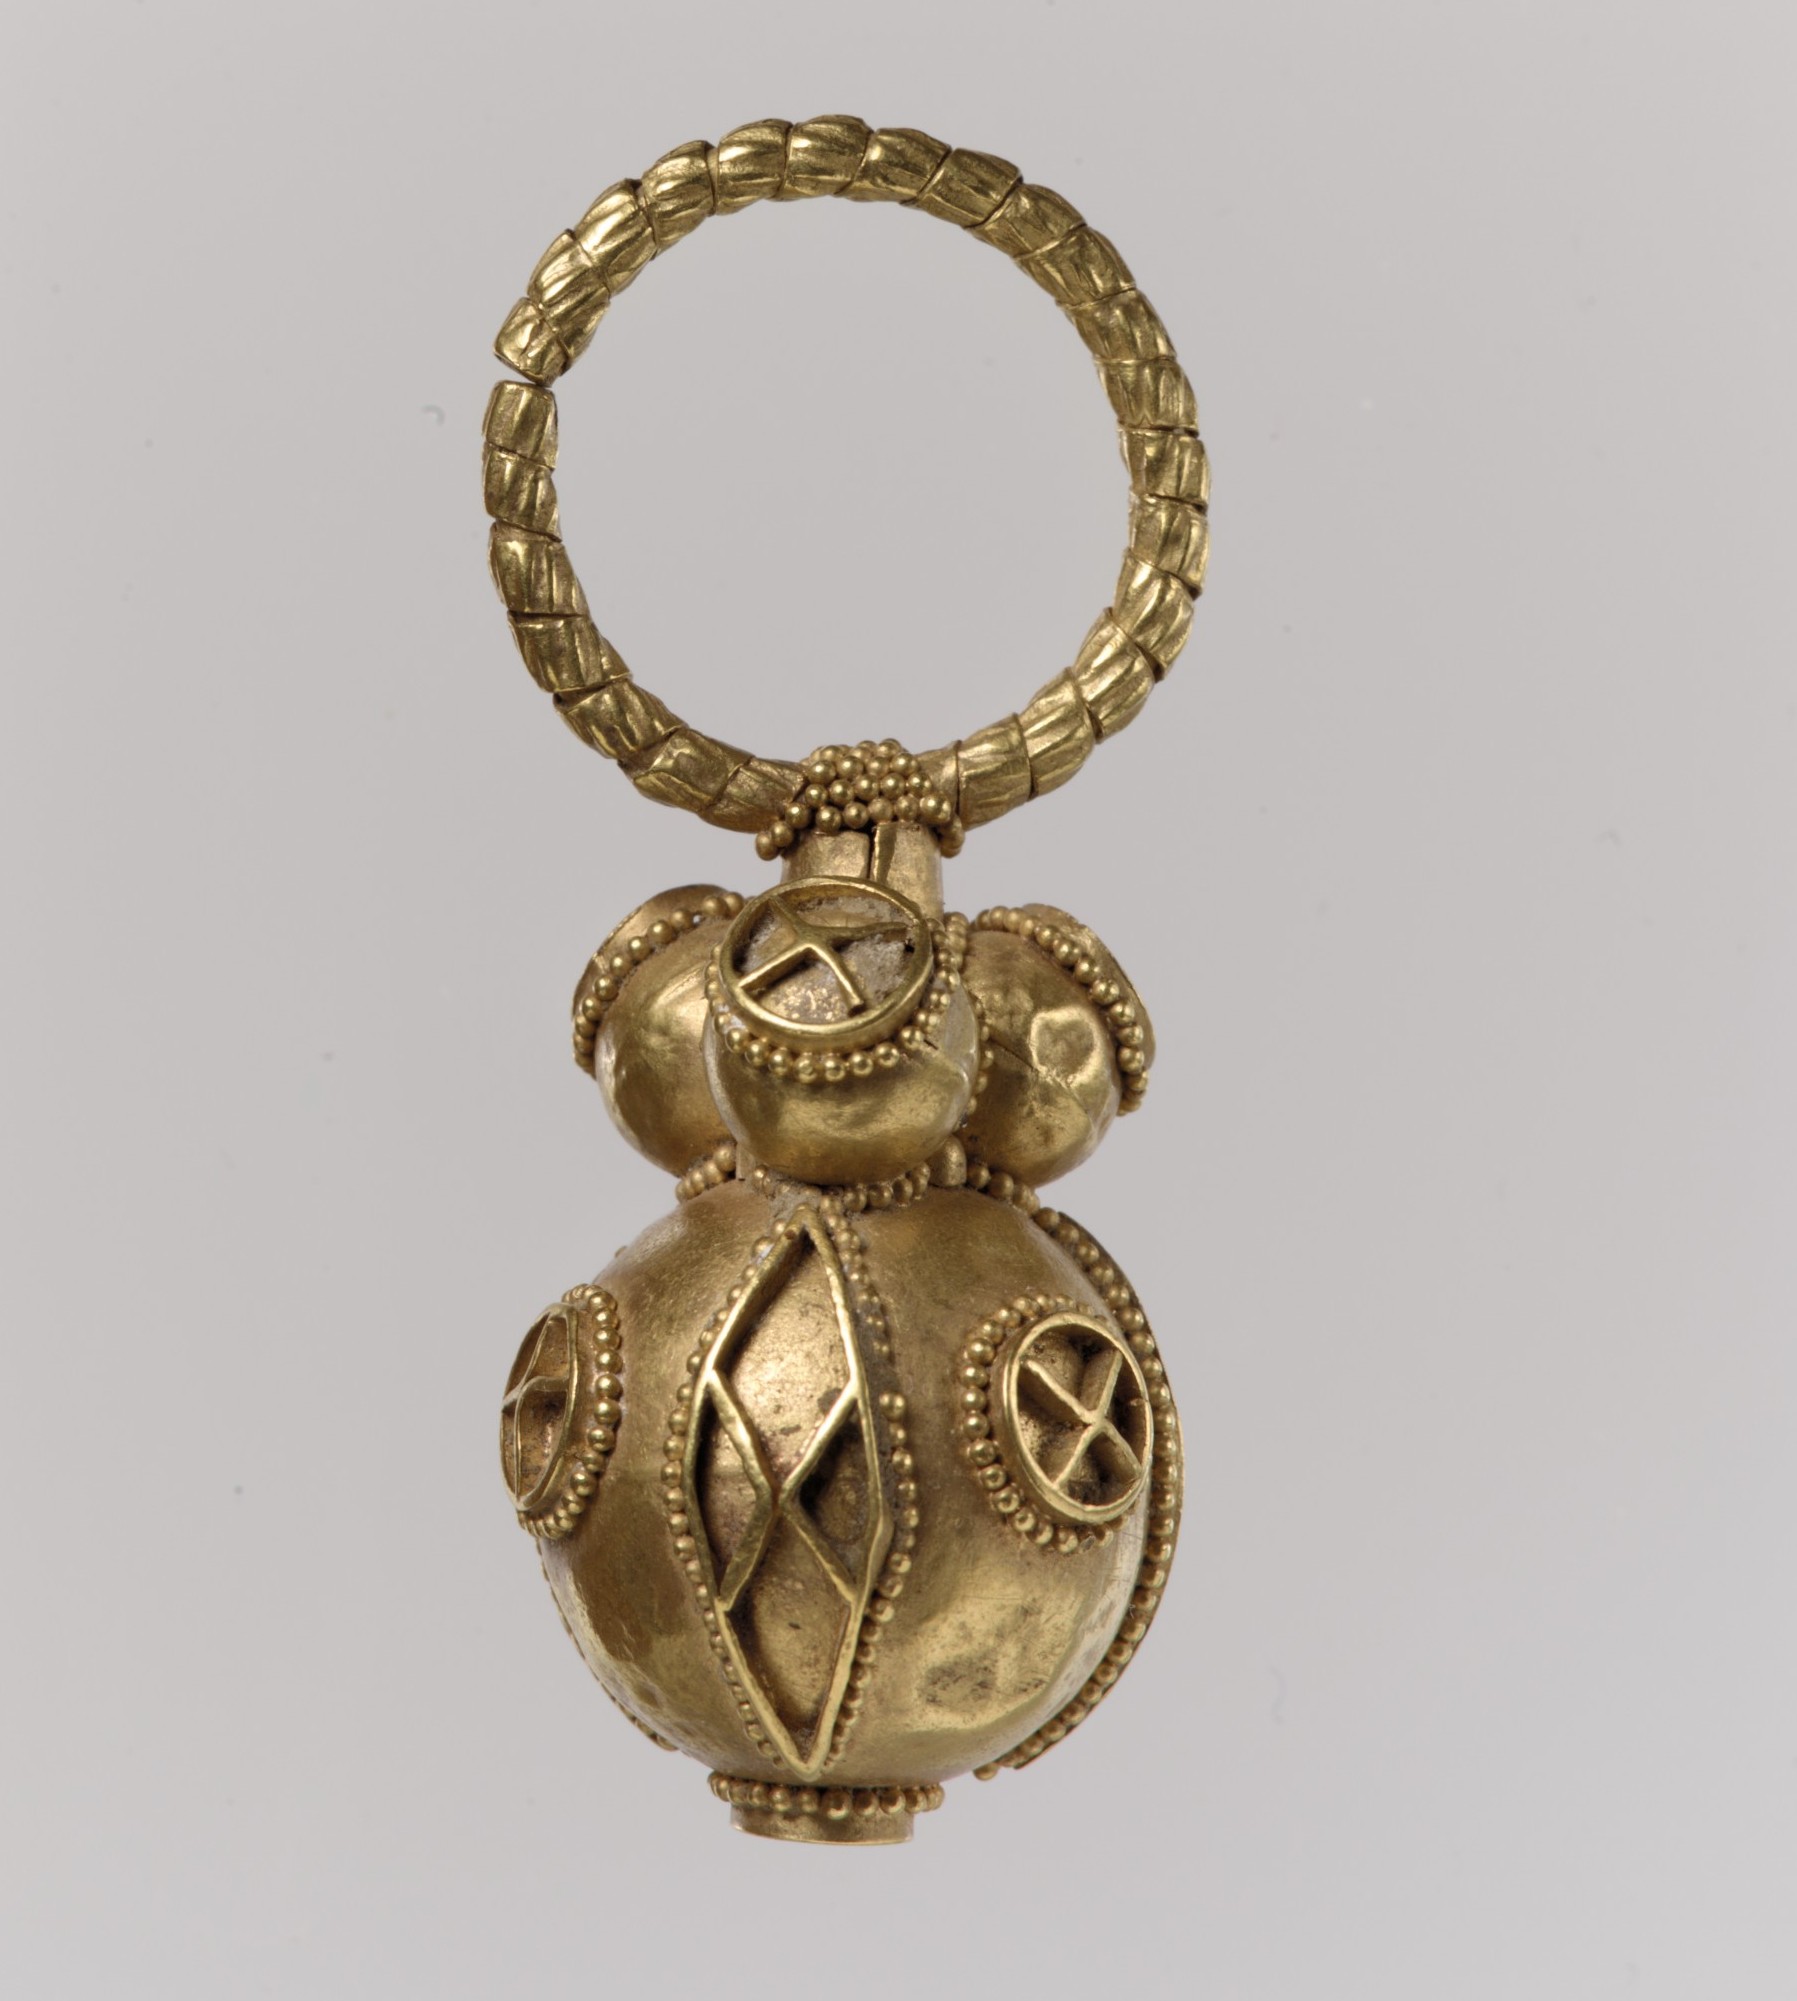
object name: earring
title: One of a Pair of Gold Earrings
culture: avar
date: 550-650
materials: gold